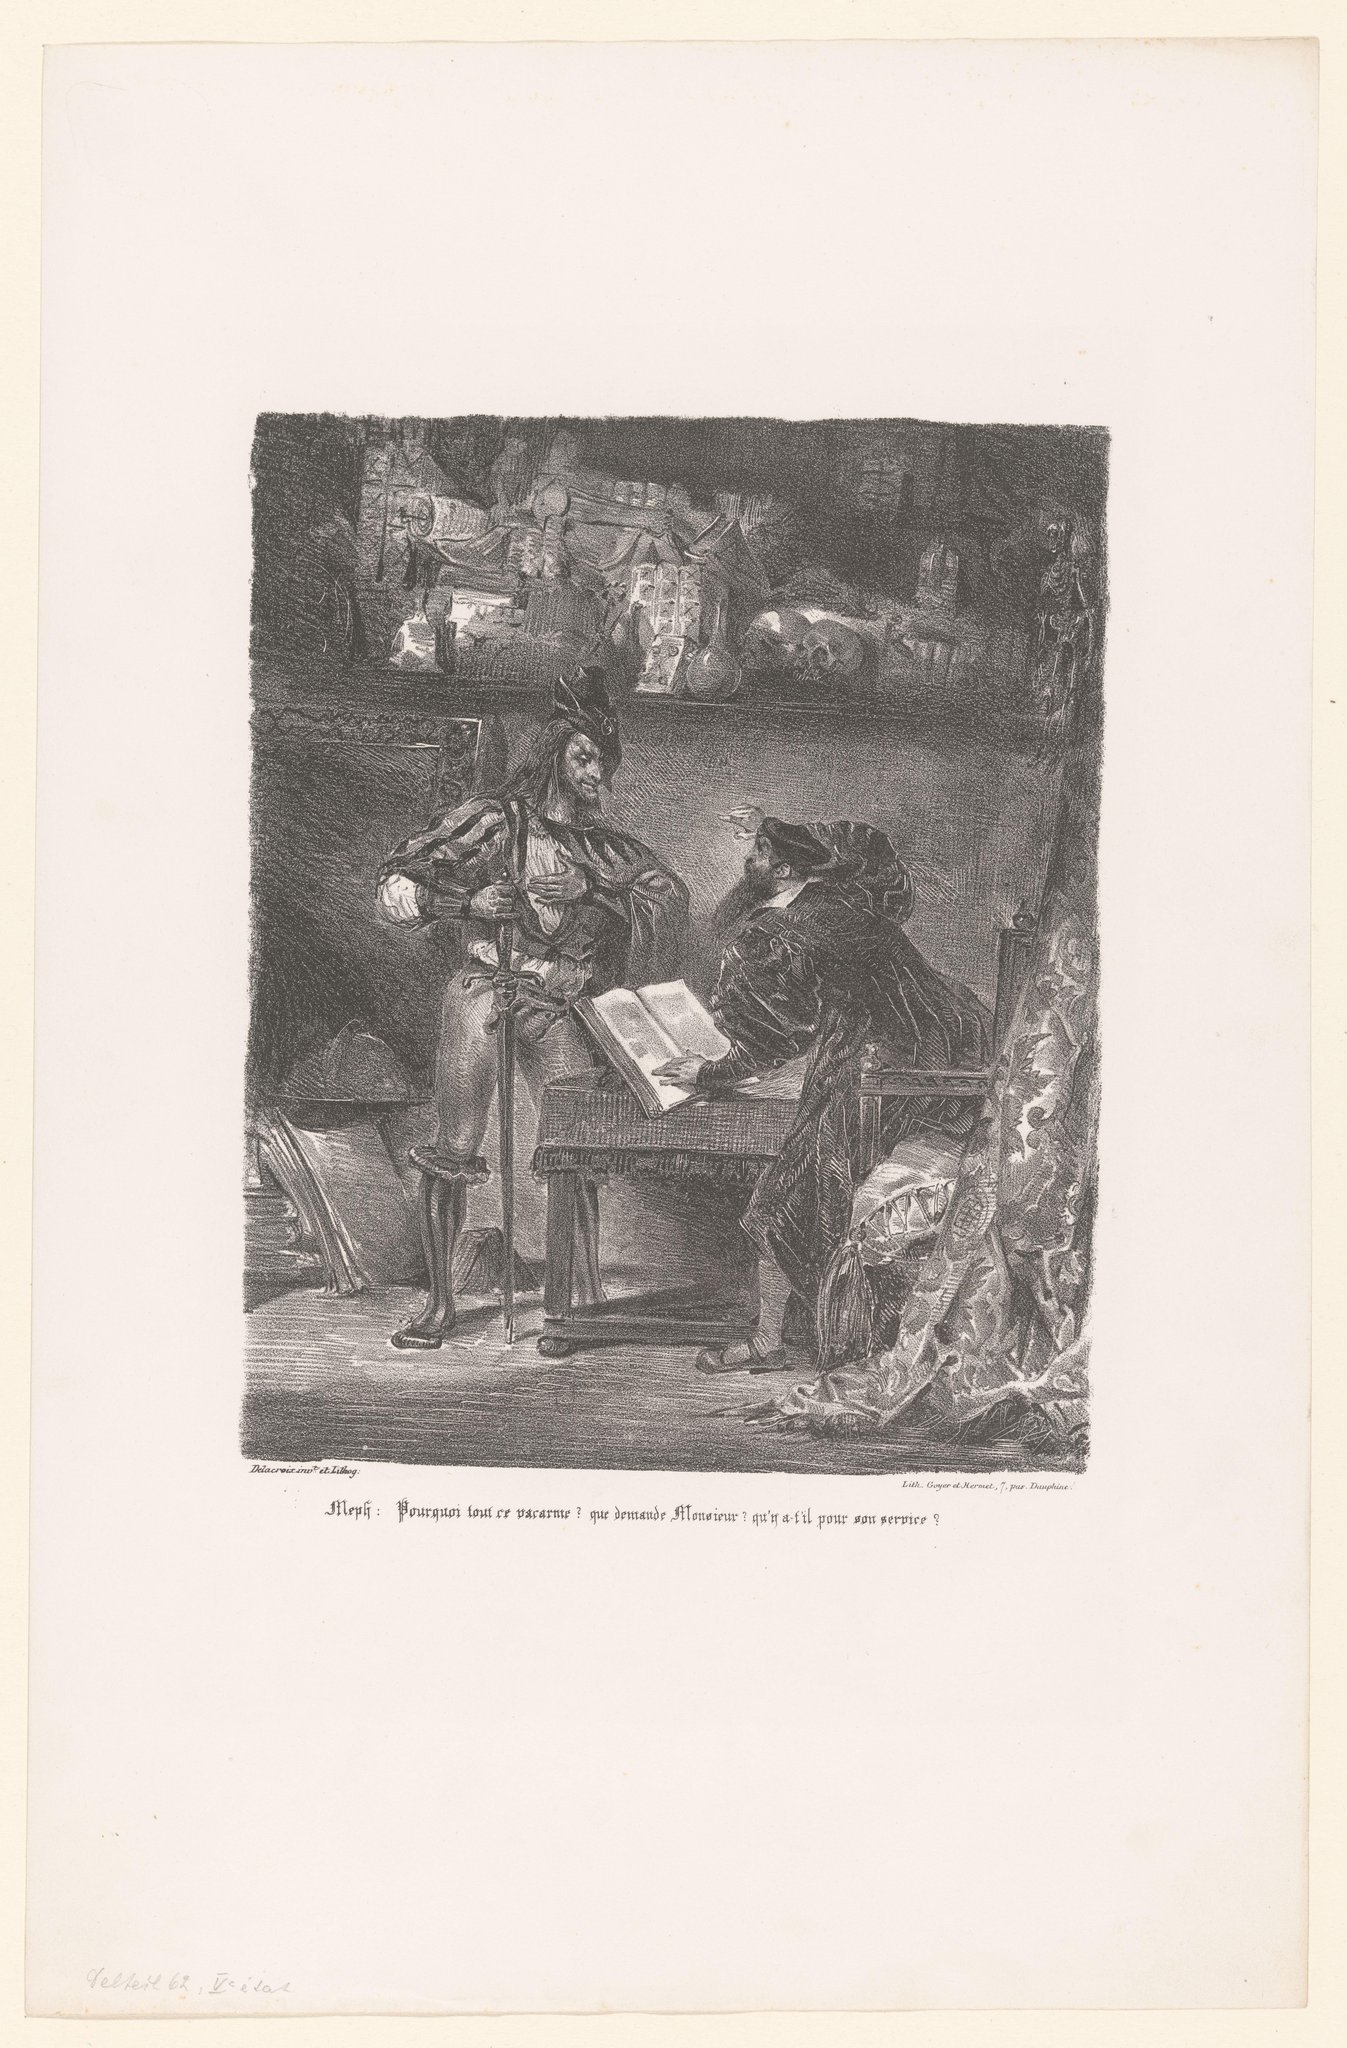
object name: print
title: Faust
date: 1828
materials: paper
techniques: lithograph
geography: paris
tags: (scenes from) specific works of literature: goethe, faust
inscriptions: collector's mark: Lugt 964, collector's mark: Lugt 2228a